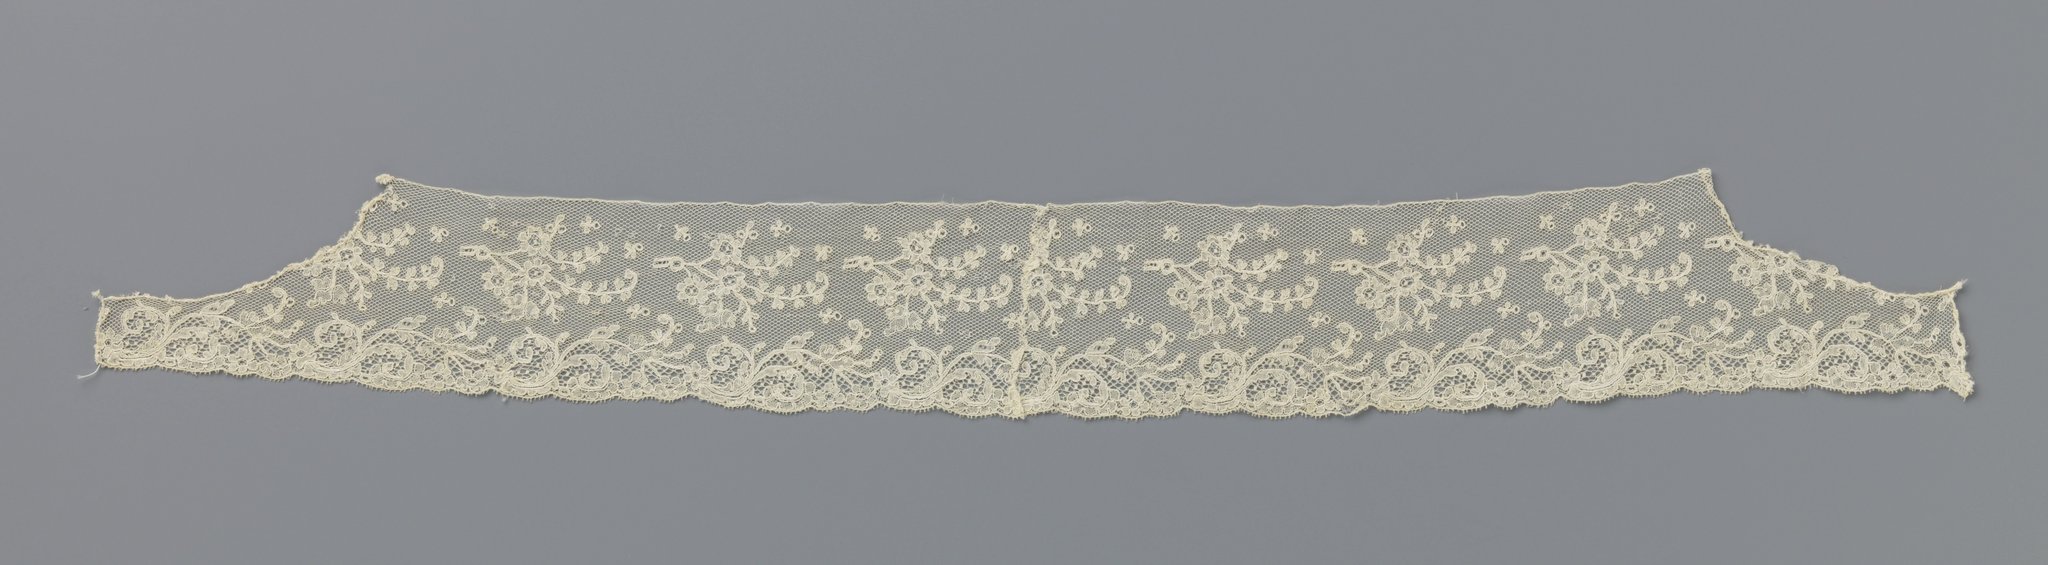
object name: strip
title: Strook kloskant met liggende bloemtakjes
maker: Anonymous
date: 1830-1850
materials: linen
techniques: lace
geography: ieper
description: Op een fijne traliegrond, een Mechelse grond (ook wel ijsgrond genoemd), staan gelijkgerichte liggende takjes, waaraan drie kleine roosjes; hiertussen enkele gestrooide bessentakjes. Een rand met open rasterwerkvulling bestaat uit aaneensluitende spiraalranken, onder andere met drie roosjes en randjes van campanes, die de schulpen vormen. Mechelse kant.